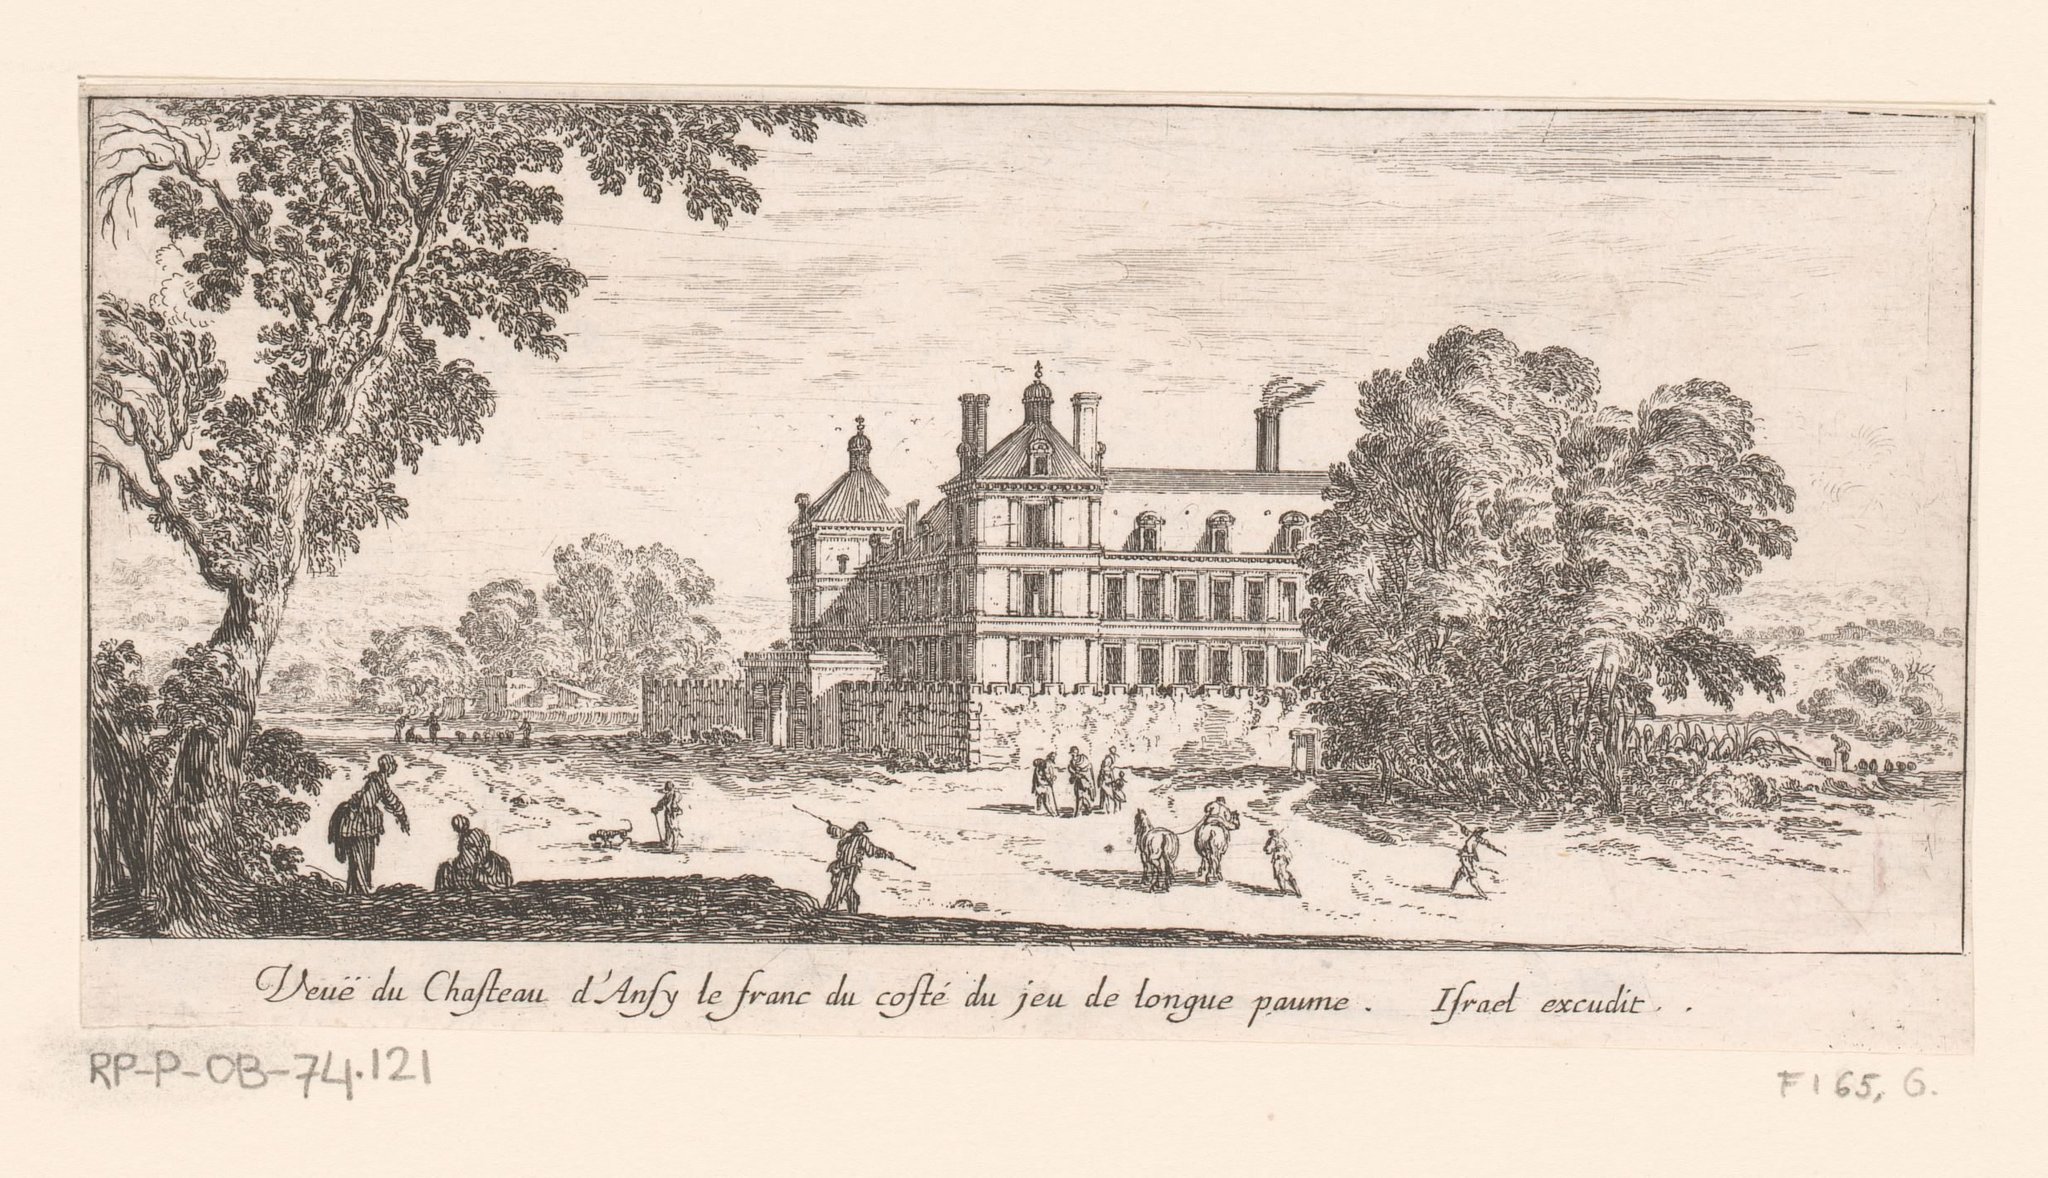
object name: print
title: Veue du Chasteau d'Ansy le franc du costé du jeu de longue paume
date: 1631-1661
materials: paper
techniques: etching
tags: landscape with tower or castle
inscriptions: collector's mark: Lugt 240